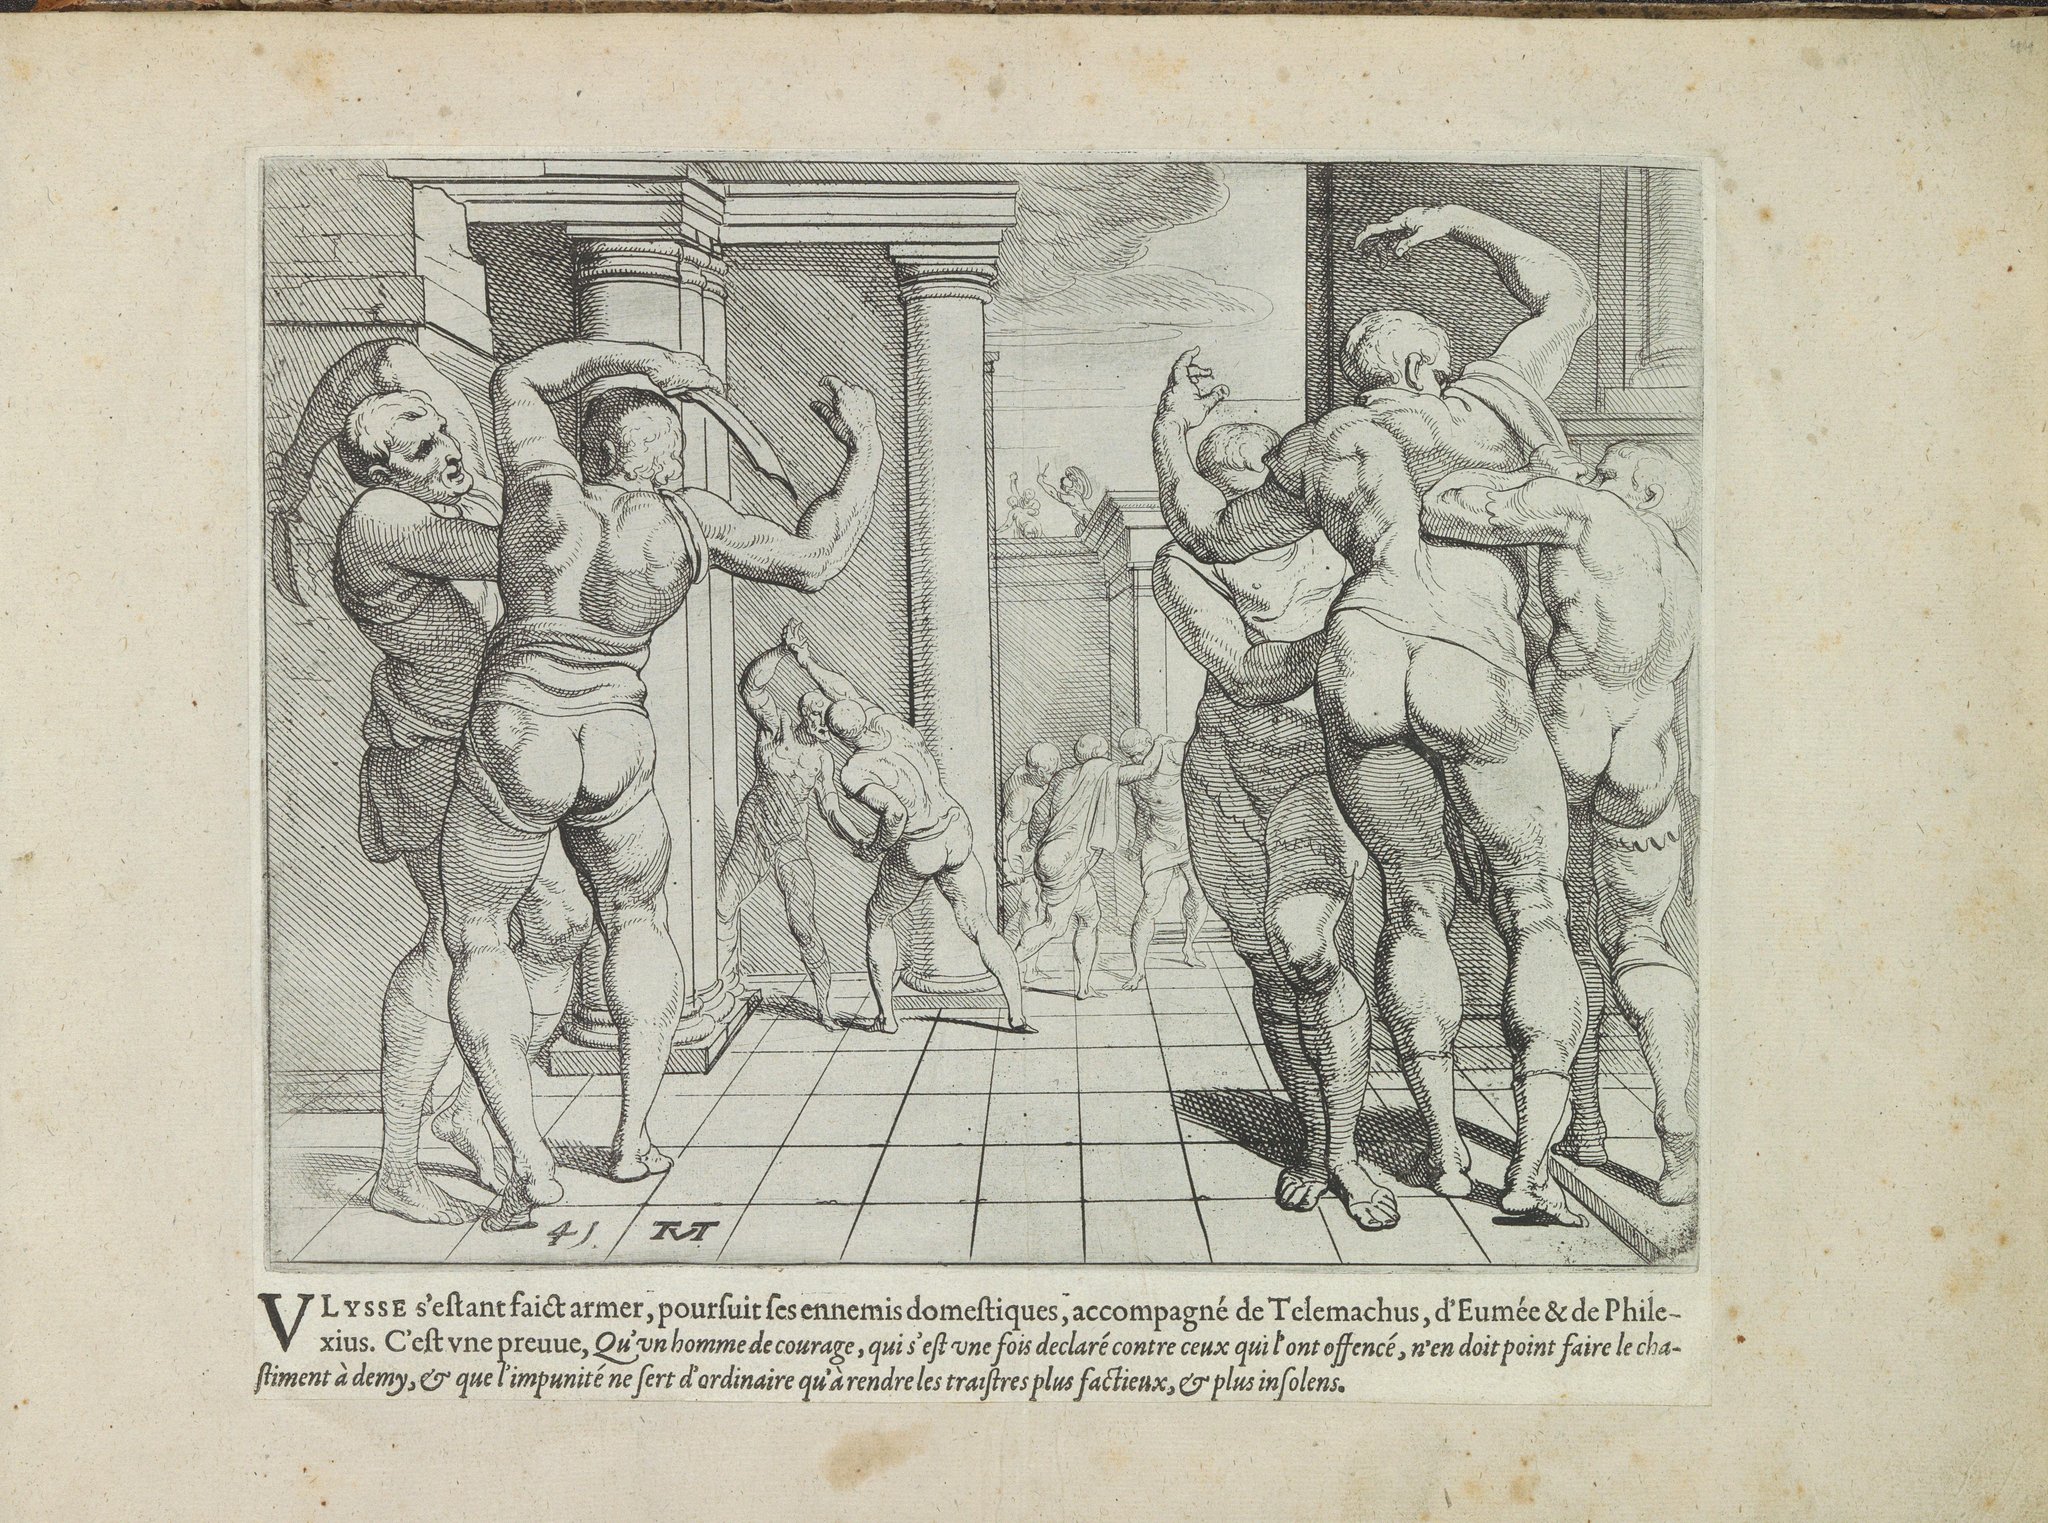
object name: album leaf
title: Les Travaux d'Ulysse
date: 1633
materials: paper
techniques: engraving, etching, letterpress printing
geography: paris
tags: ulysses, assisted by telemachus, kills the suitors (homer, odyssey xxii)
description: Odysseus doodt met hulp van zijn zoon Telemachus de vrijers van zijn vrouw Penelope. De prent maakt deel uit van een album.